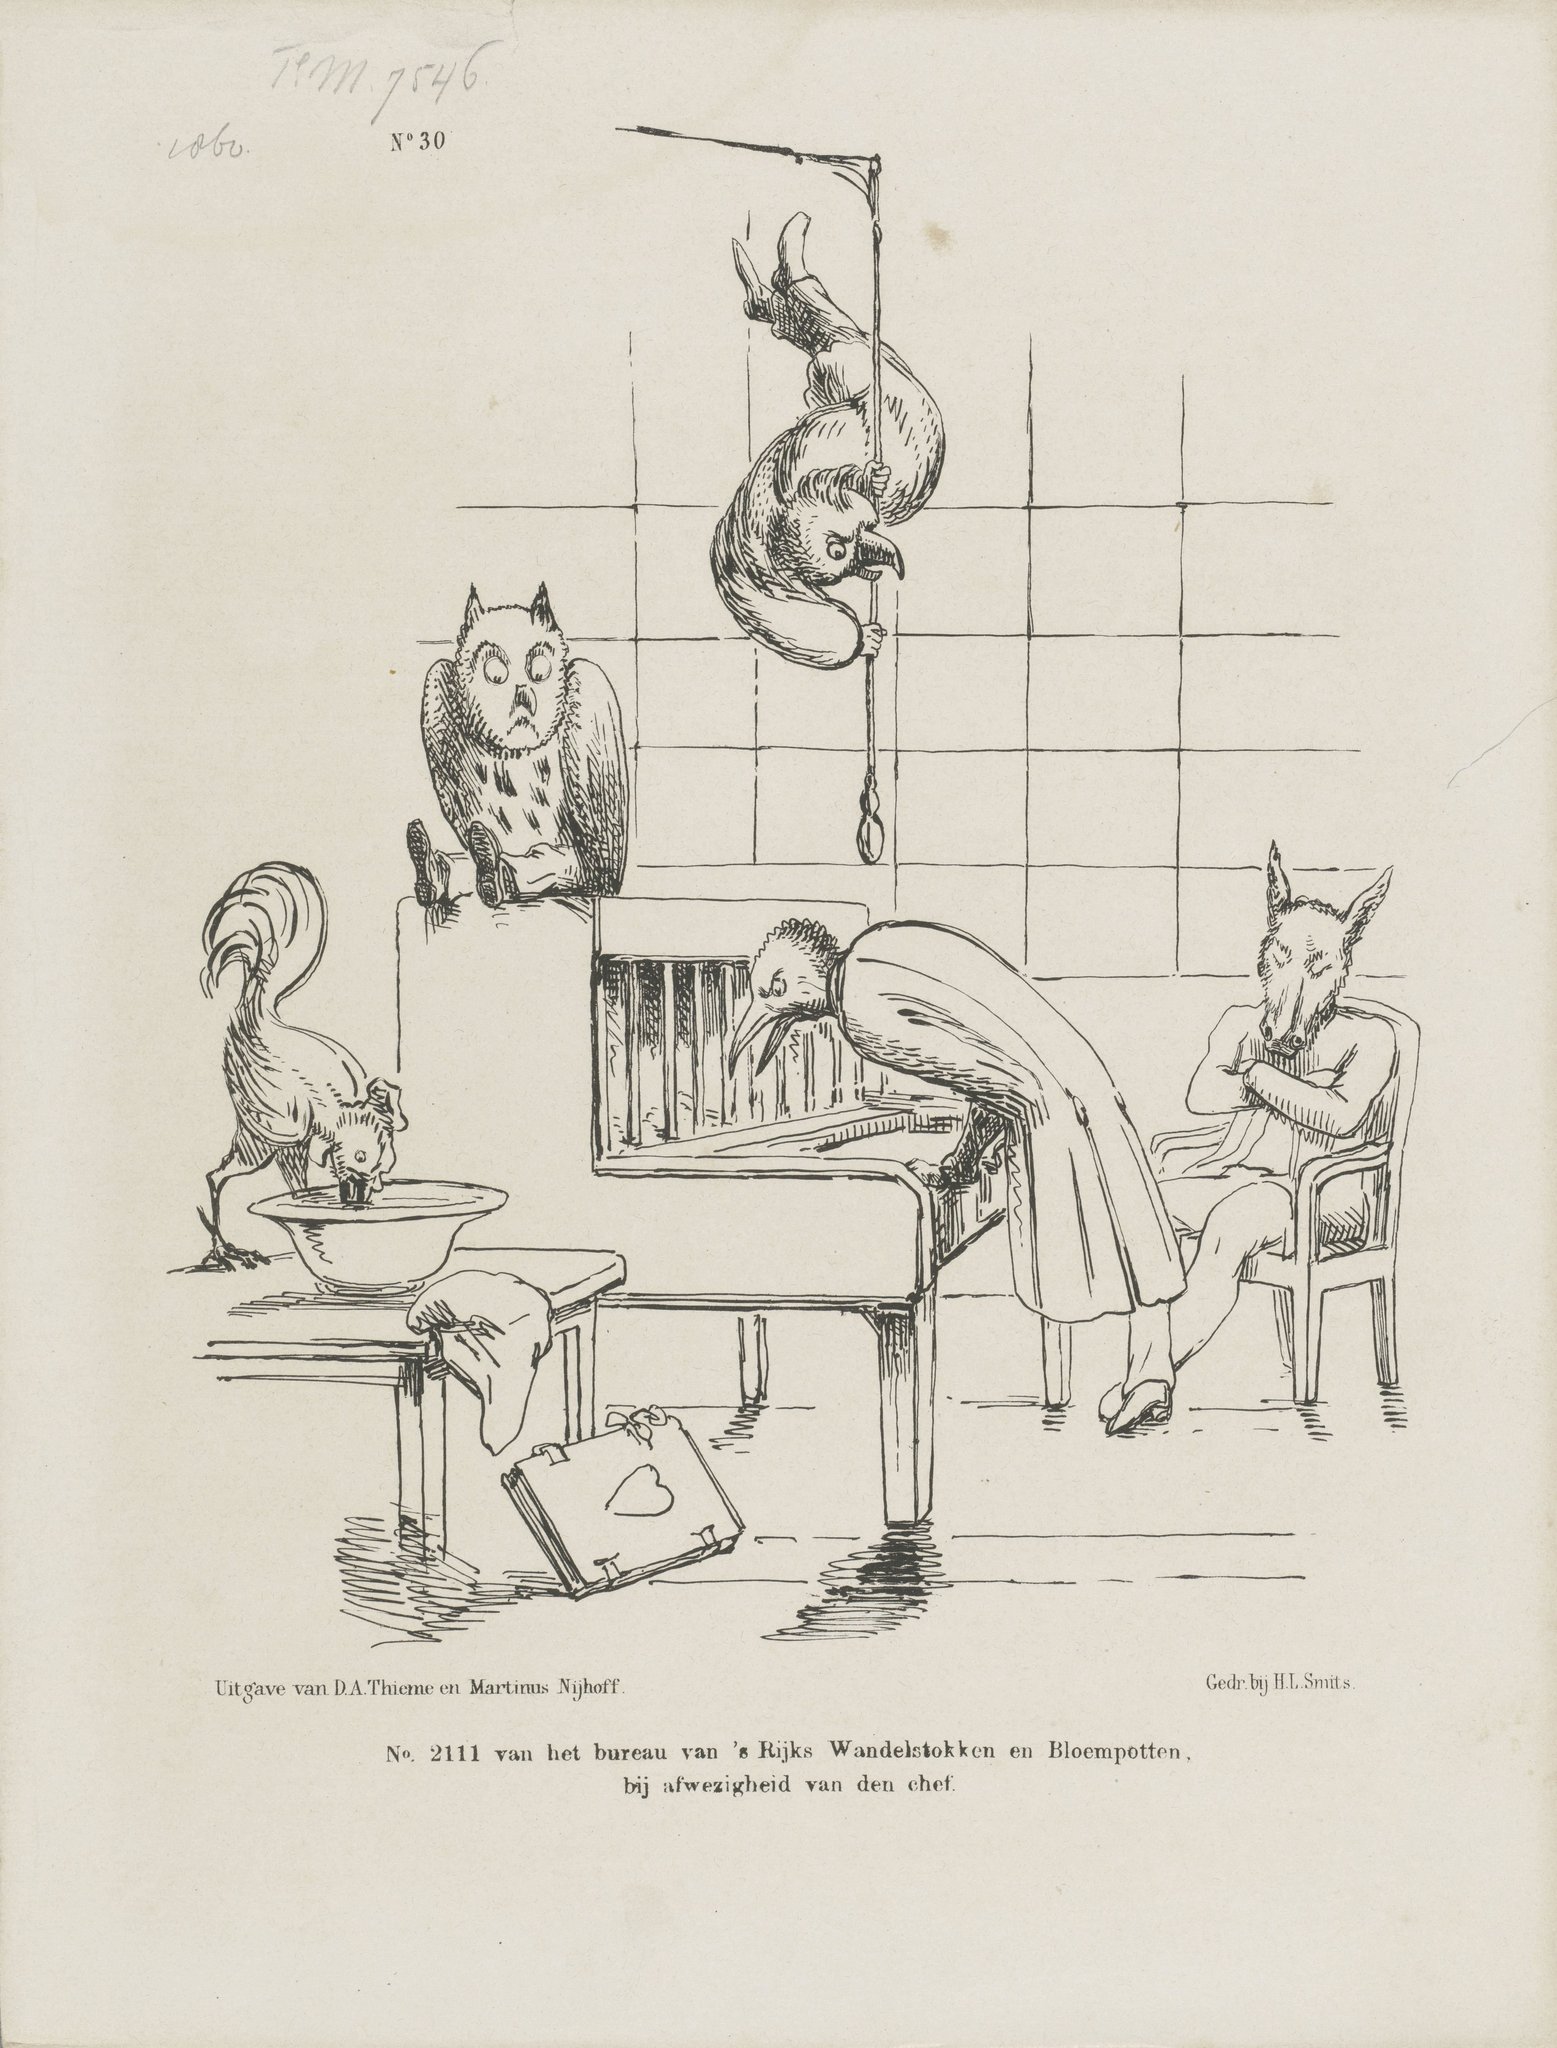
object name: print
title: No. 2111 van het bureau van 's Rijks Wandelstokken en Bloempotten, bij afwezigheid van den chef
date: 1860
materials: paper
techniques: lithograph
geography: arnhem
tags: official; civil servant; functionary (in general), animals acting as human beings, the hague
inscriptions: collector's mark: Lugt 2228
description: Spotprent op ledigheid van ambtenaren op de ministeriële departementen bij afwezigheid van het hoofd van de afdeling. Kamer met verschillende, deels verklede, vogels, een ezel slaapt in een stoel. Plaat verschenen bij het weekblad De Nederlandsche Spectator, nr. 30, 28 juli 1860.